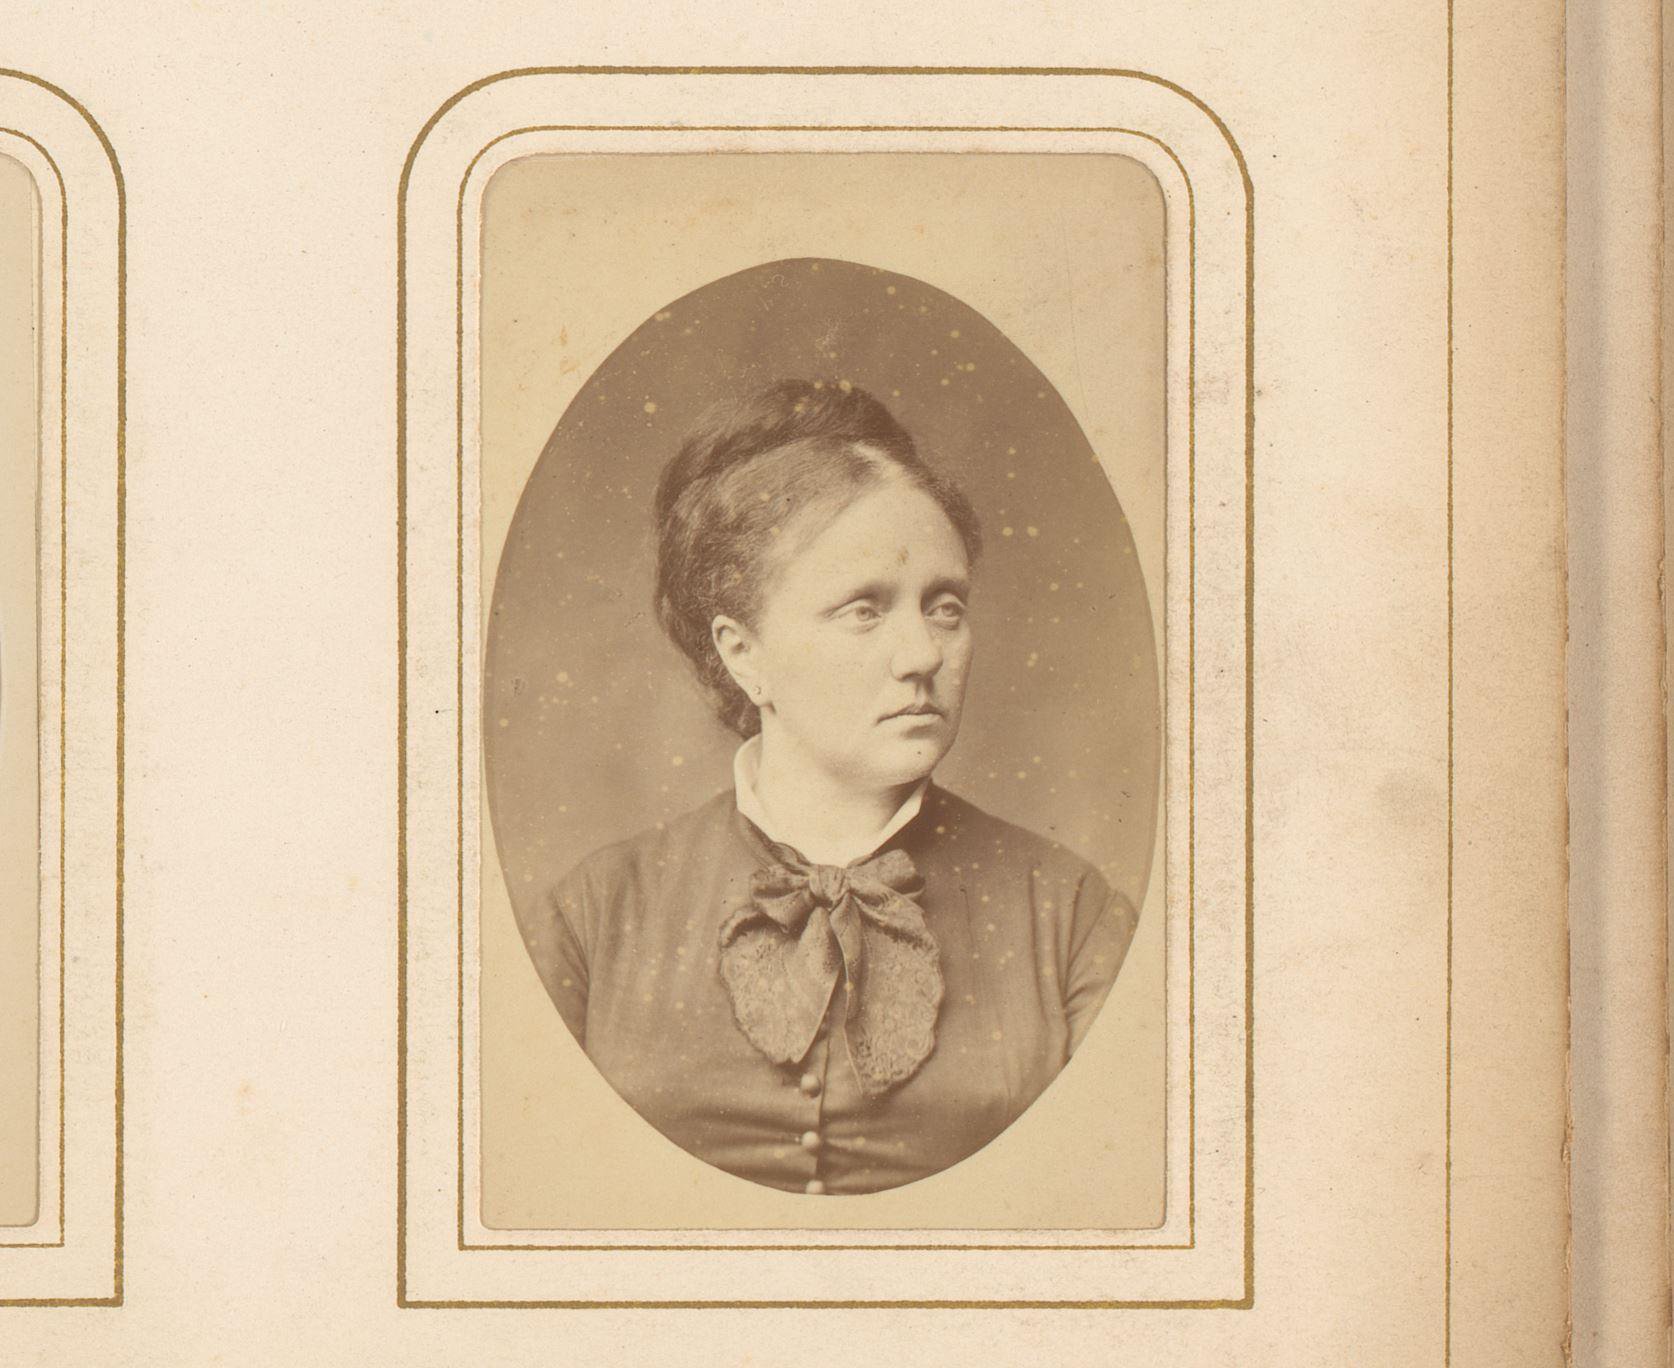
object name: photograph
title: Portret van een vrouw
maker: eugene guérin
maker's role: fotograaf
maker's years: 1845-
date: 1809-1877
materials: cardboard, photographic support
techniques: albumen print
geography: brussels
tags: historical persons - bb - woman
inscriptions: inscription: ‘Eugène Guérin/ 142, Rue Royale, 142/ Bruxelles’, annotation: ‘Septembre 1877/ M[.]. [..]iria[..]n.’